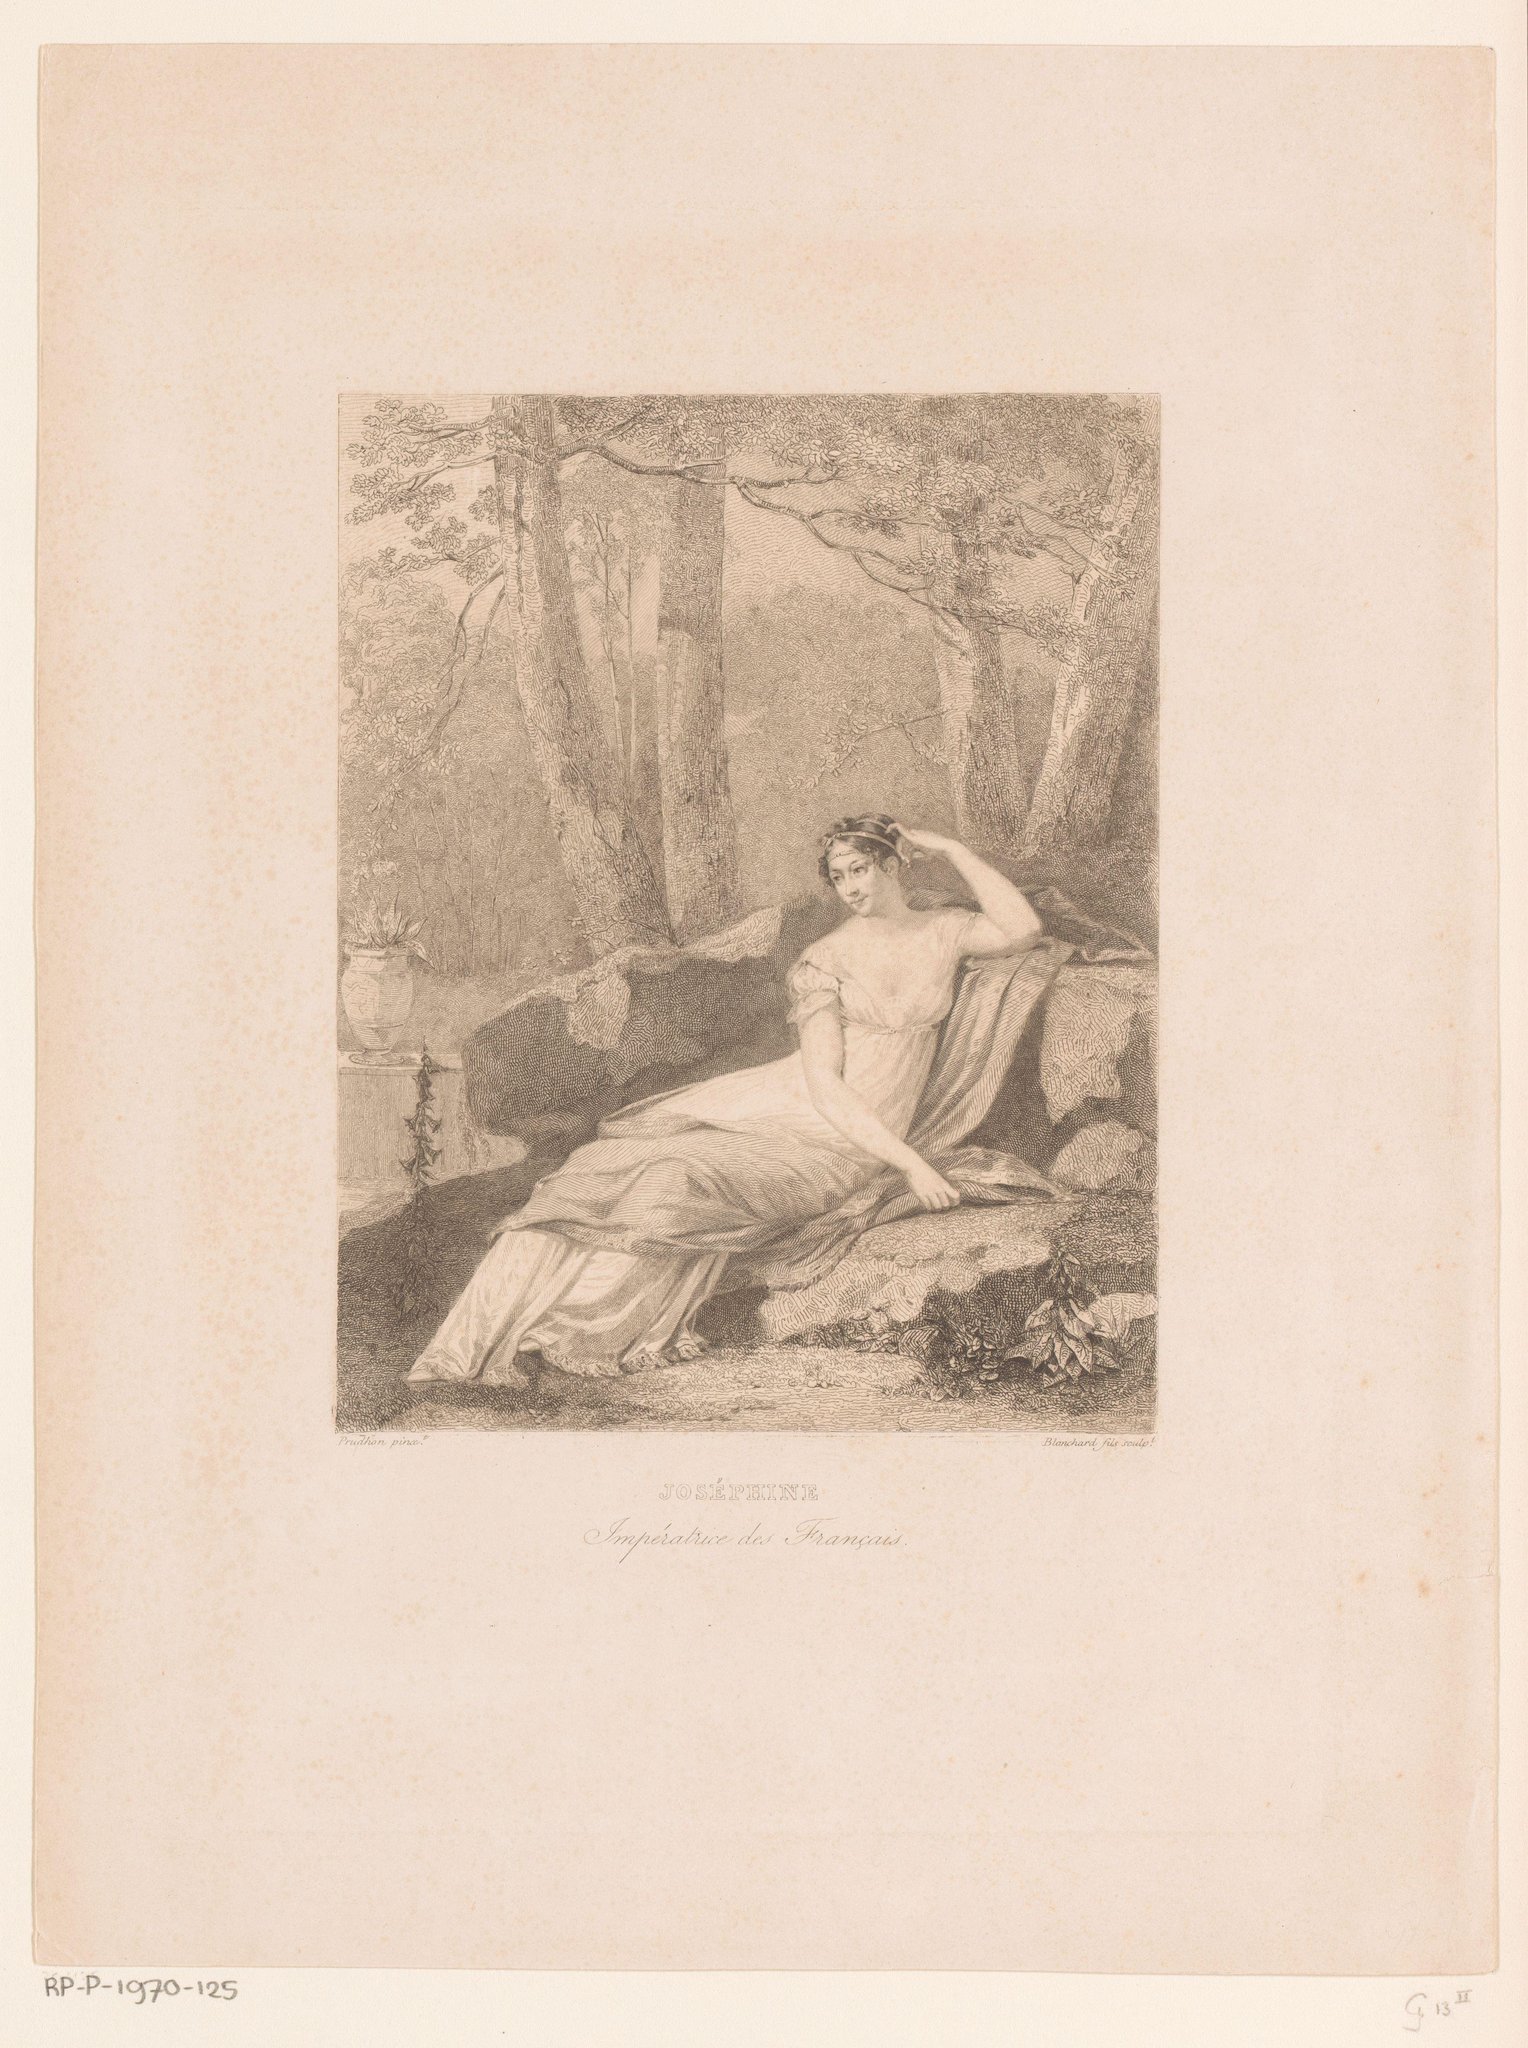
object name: print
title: Joséphine/ Impératrice des Français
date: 1829-1898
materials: paper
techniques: etching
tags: joséphine de beauharnais, historical persons, emperor - bb - female ruler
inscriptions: collector's mark: Lugt 2228a, collector's mark: Lugt 2760